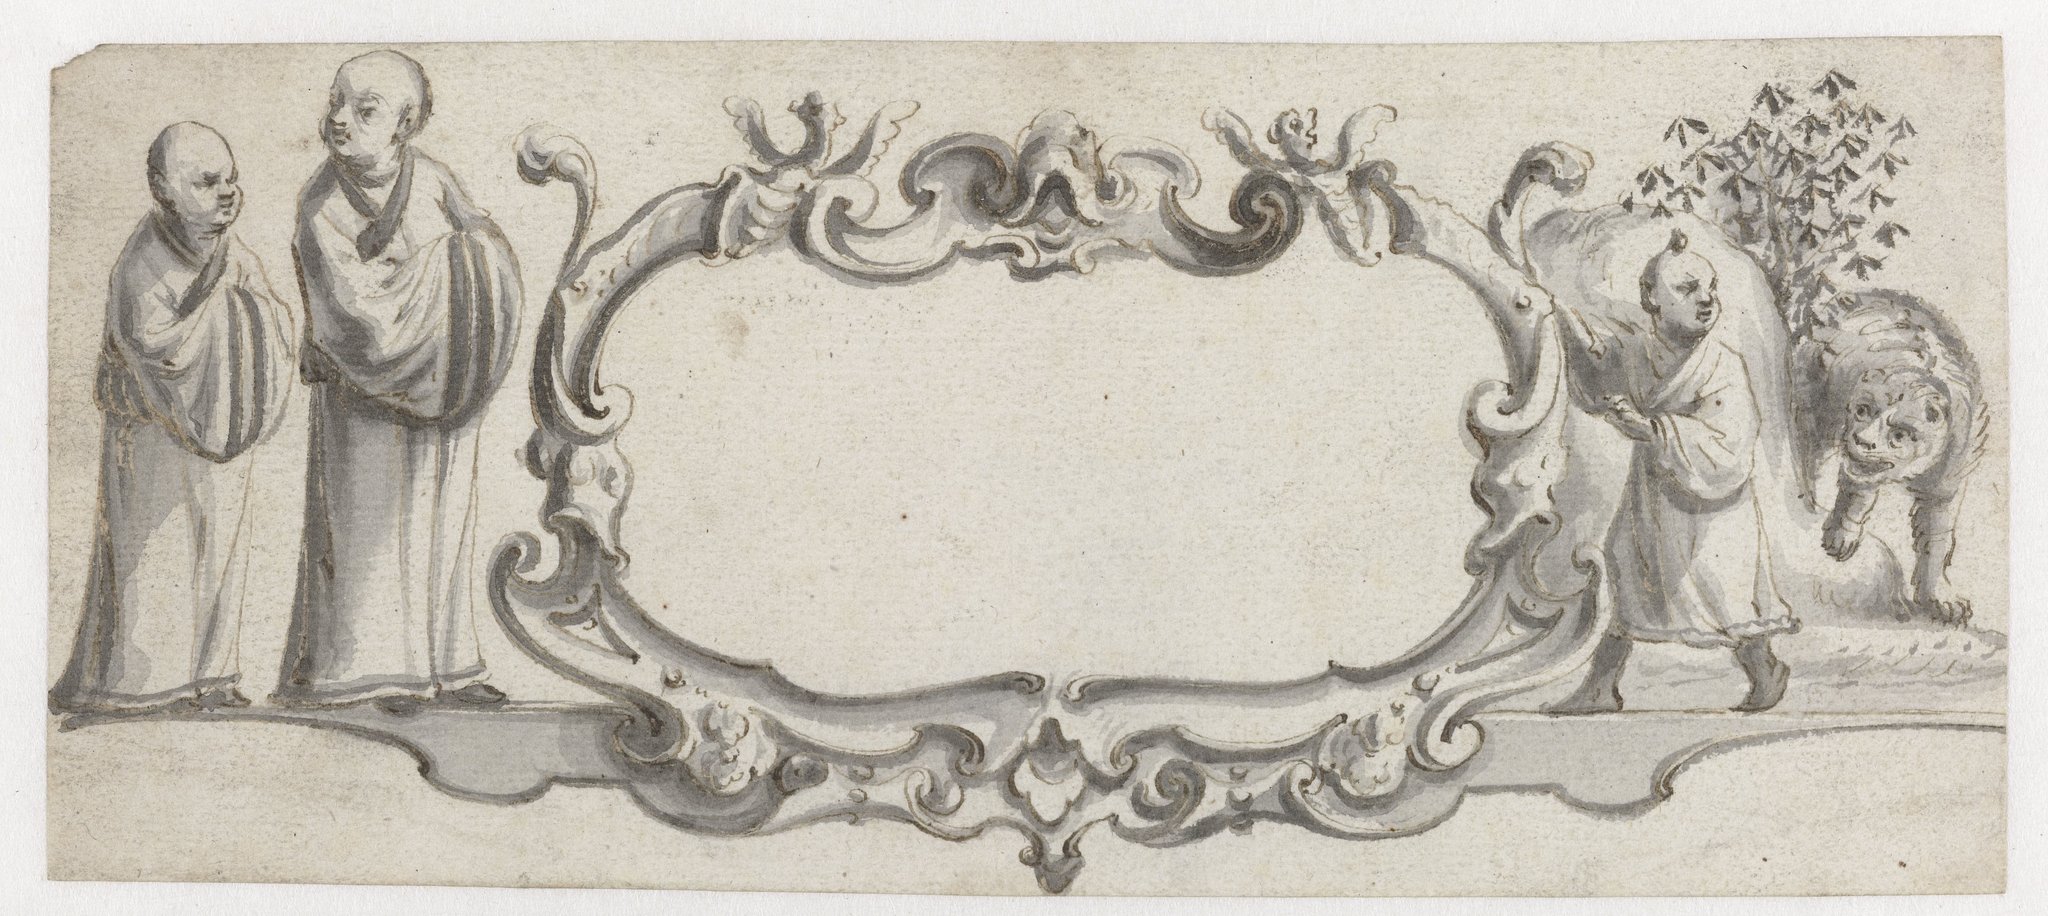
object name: drawing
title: Rechthoekige cartouche met drie Chinezen en een tijger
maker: pieter jansz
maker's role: draughtsman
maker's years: 1602-1672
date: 1650-1655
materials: ink, paper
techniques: brush, pen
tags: beasts of prey, predatory animals: tiger, chinese, ornament ~ cartouche